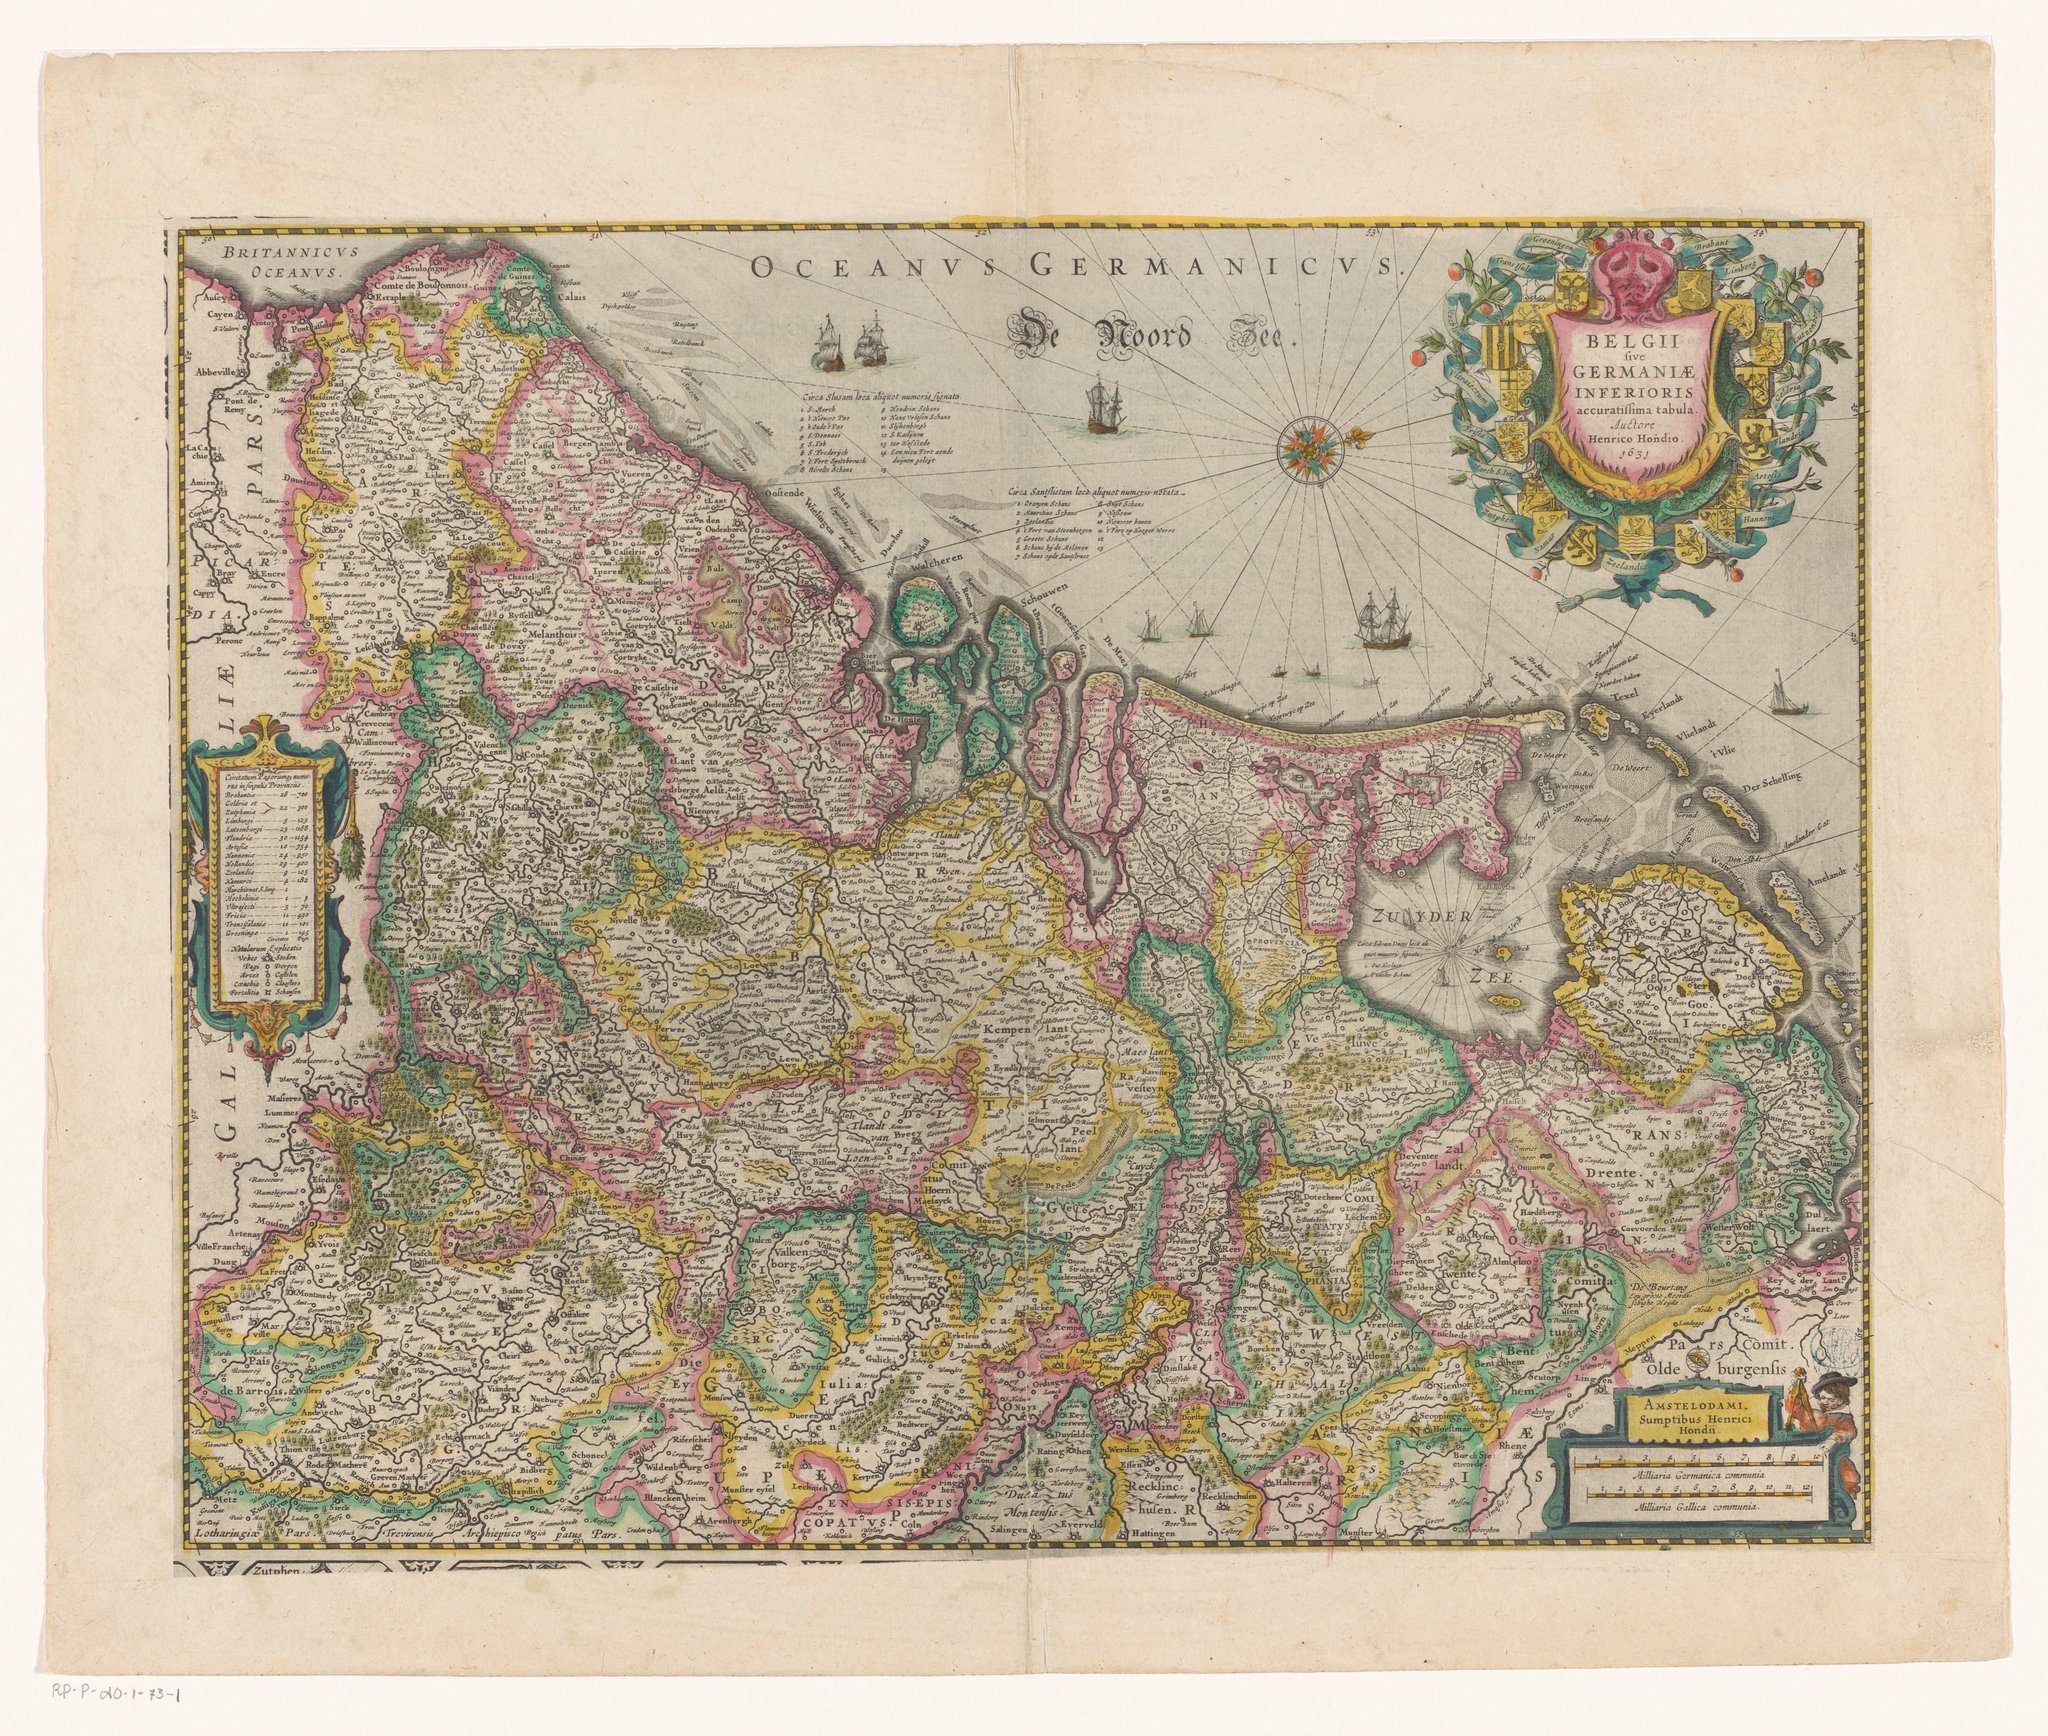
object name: print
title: Kaart van de Nederlanden, 1631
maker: henricus hondius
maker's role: print maker, publisher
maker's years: 1597-1651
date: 1631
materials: paper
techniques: engraving, hand coloring, letterpress printing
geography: amsterdam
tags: coat of arms (as symbol of the state, etc.), maps of separate countries or regions, low countries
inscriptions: collector's mark: Lugt 195, collector's mark: Briquet 2228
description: Links een cartouche met een overzicht met topografische informatie over iedere provincie. Rechtsboven titelcartouche in de vorm van een schild omringd door de wapens van de Zeventien Provinciën. Rechtsonder cartouche met schaalstok: Milliaria Germanica communia, Milliaria Gallica communia. Gradenverdeling langs de randen. Oriëntatie: noorden rechts. Op verso Franse tekst.